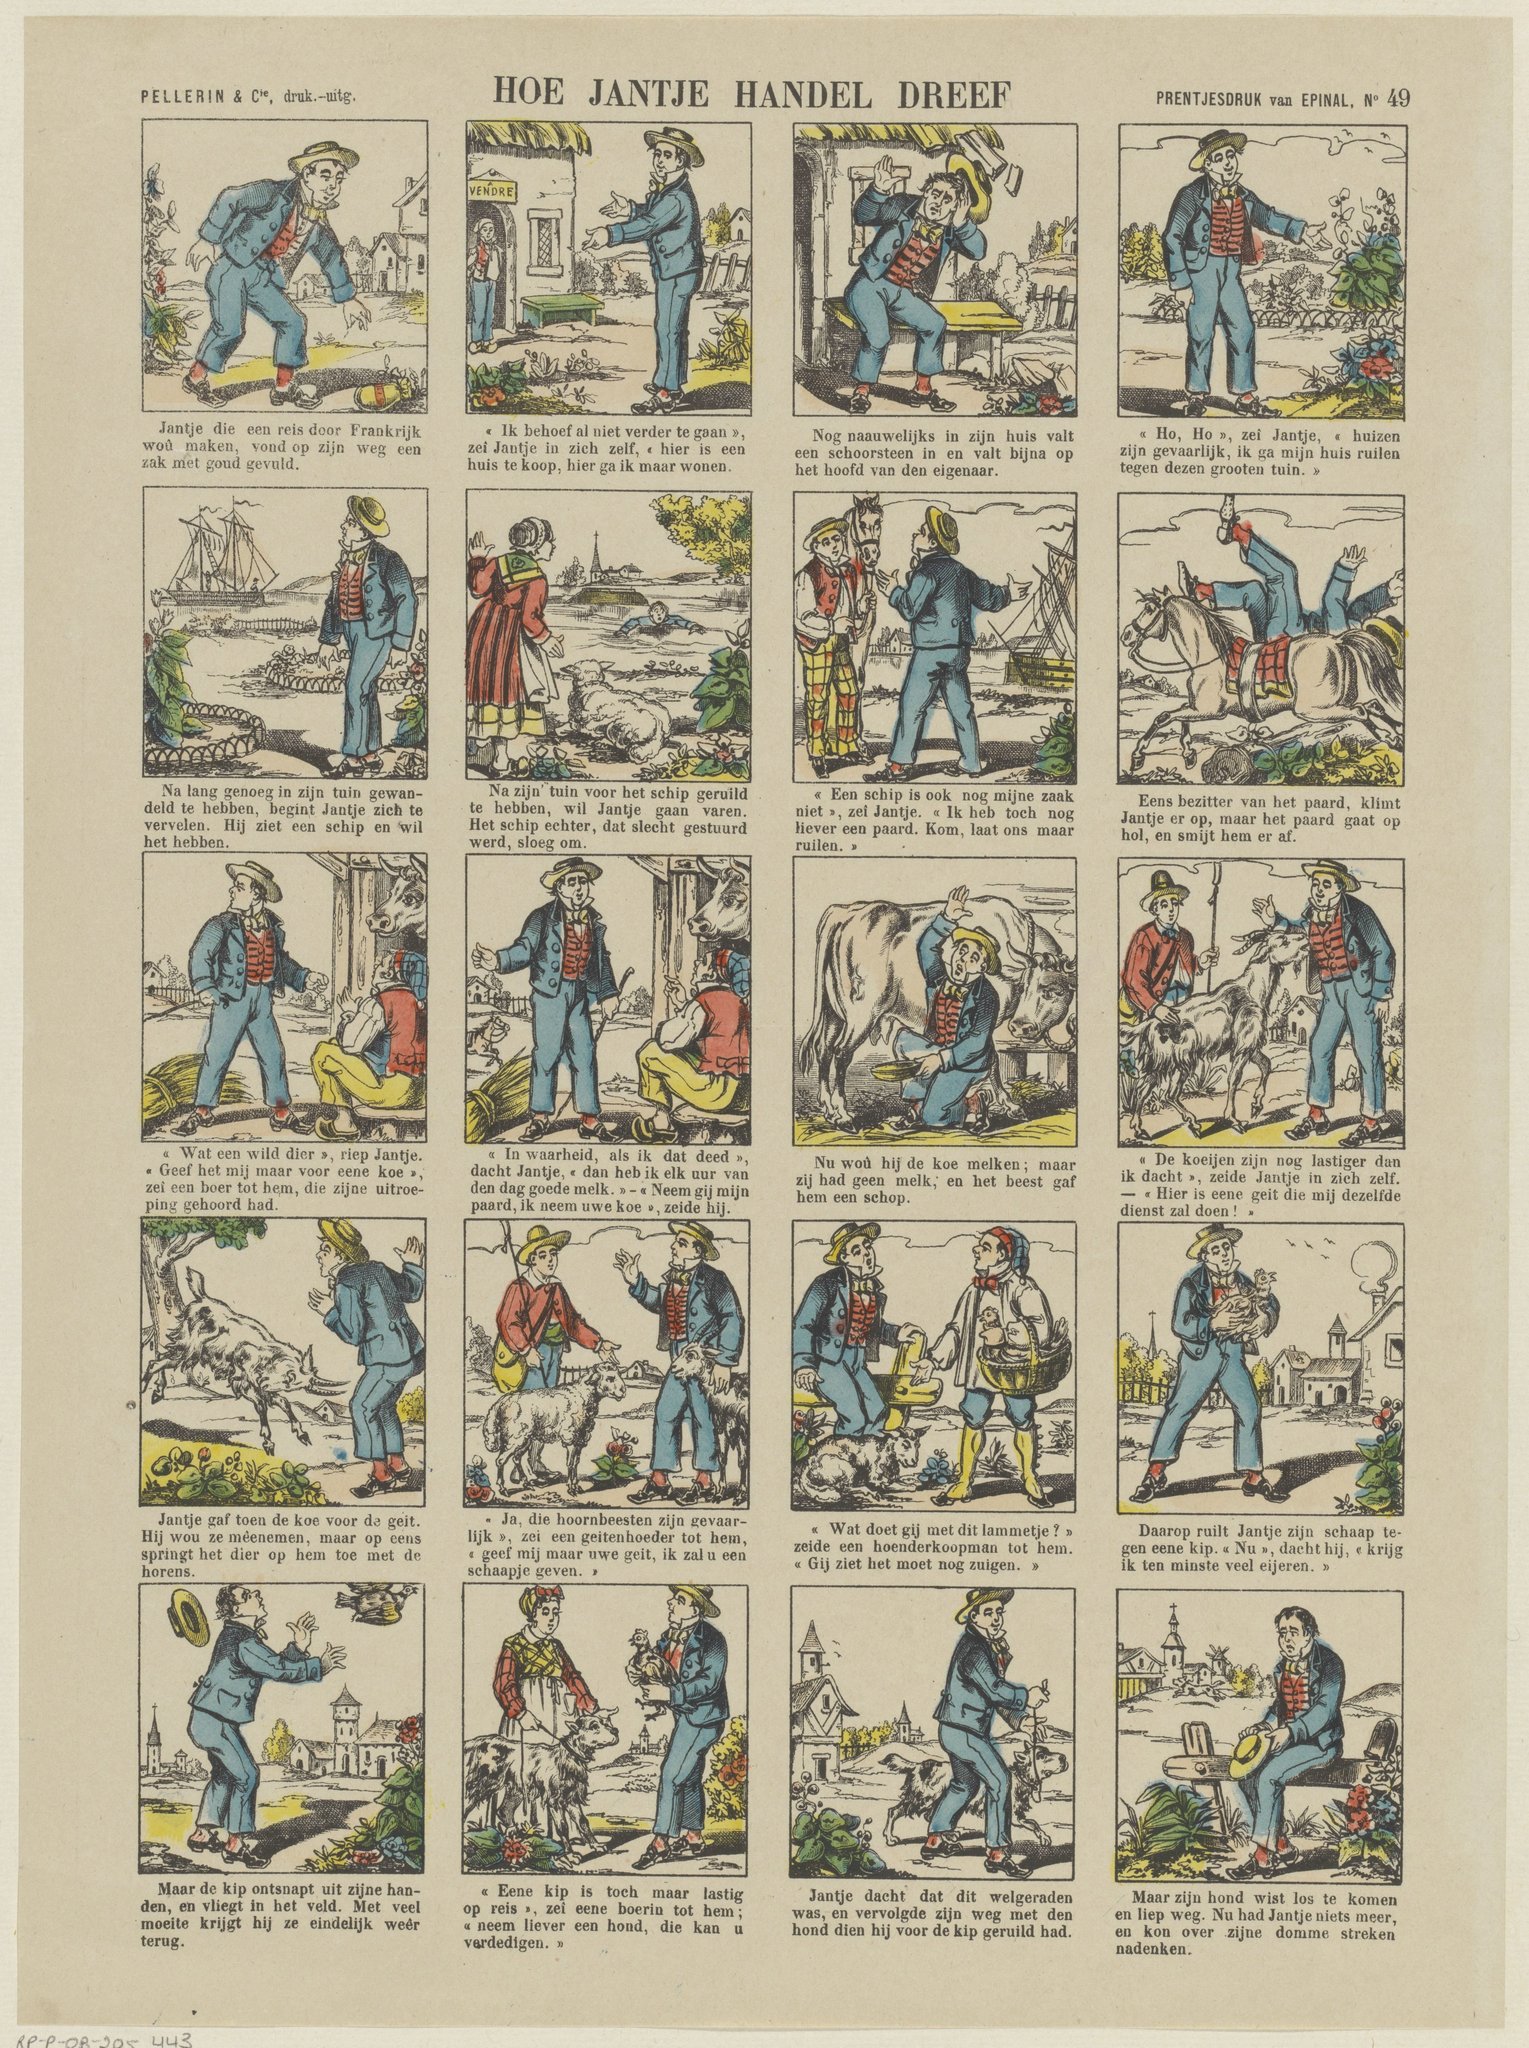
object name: popular print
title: Prentjesdruk van Épinal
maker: Anonymous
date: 1902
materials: paper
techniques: colour, letterpress printing, lithograph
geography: epinal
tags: change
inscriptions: collector's mark: Lugt 2760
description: Blad met 20 voorstellingen over Jantje die telkens zijn bezittingen ruilt voor iets anders. Onder elke afbeelding een onderschrift. Genummerd rechtsboven: No 49.